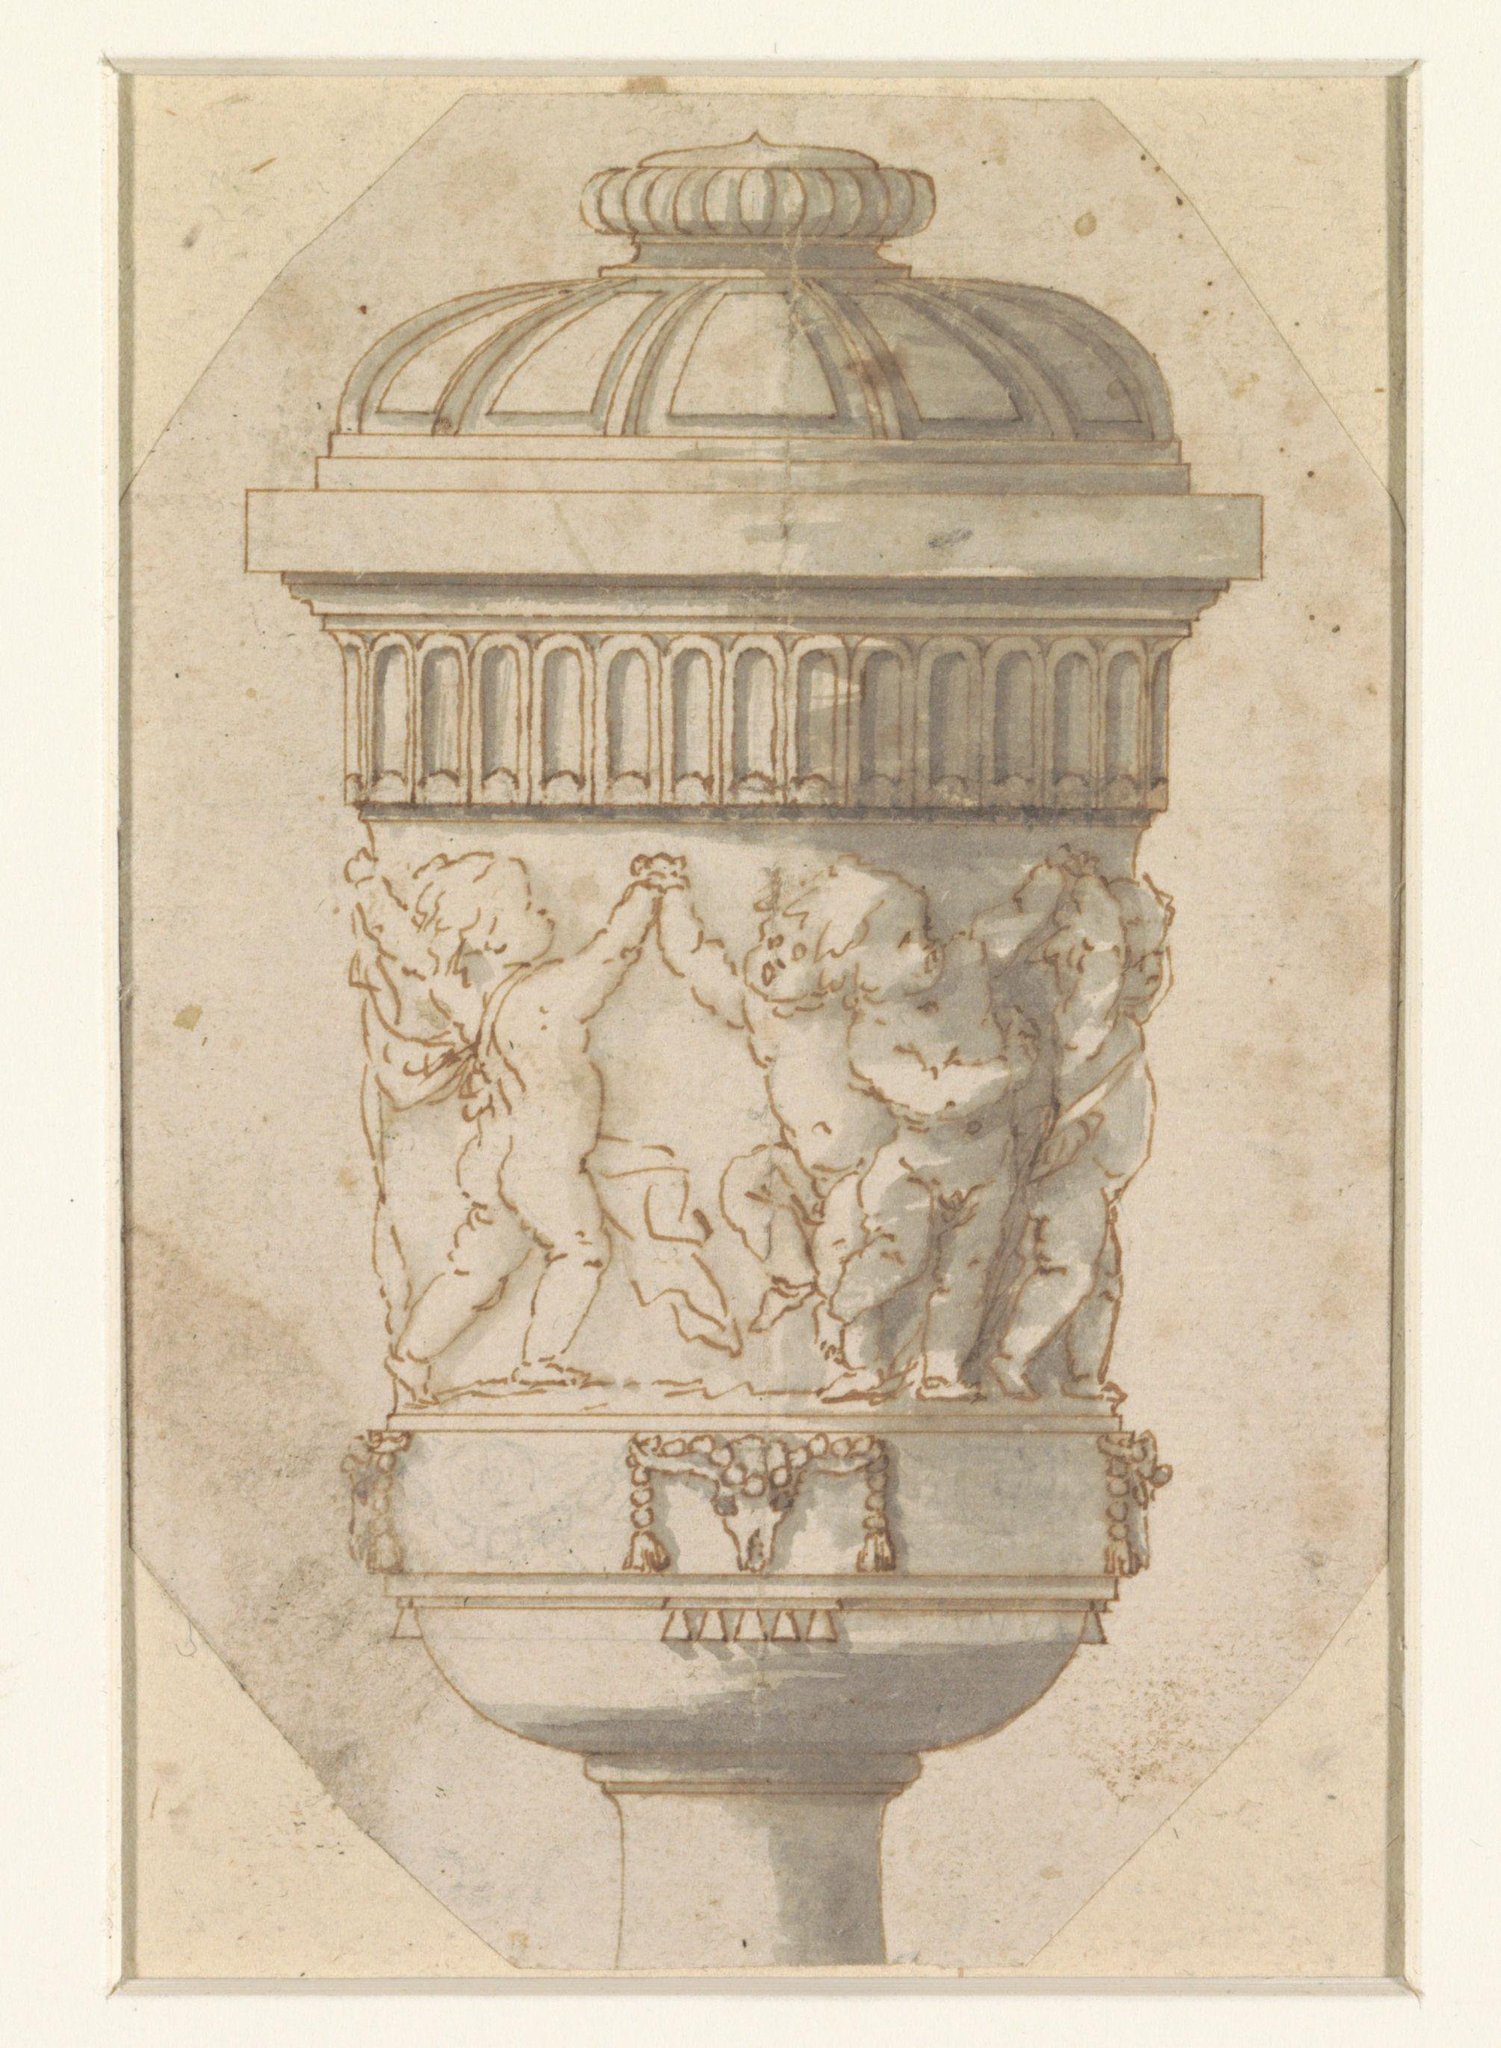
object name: ornamenttekening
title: Vaas met putti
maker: Anonymous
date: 1700-1800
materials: ink, paper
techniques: brush, pen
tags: vase ~ ornament, cupids: 'amores', 'amoretti', 'putti'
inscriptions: collector's mark: Lugt 2228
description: Een geornamenteerde vaas met een fries van dansende putti.